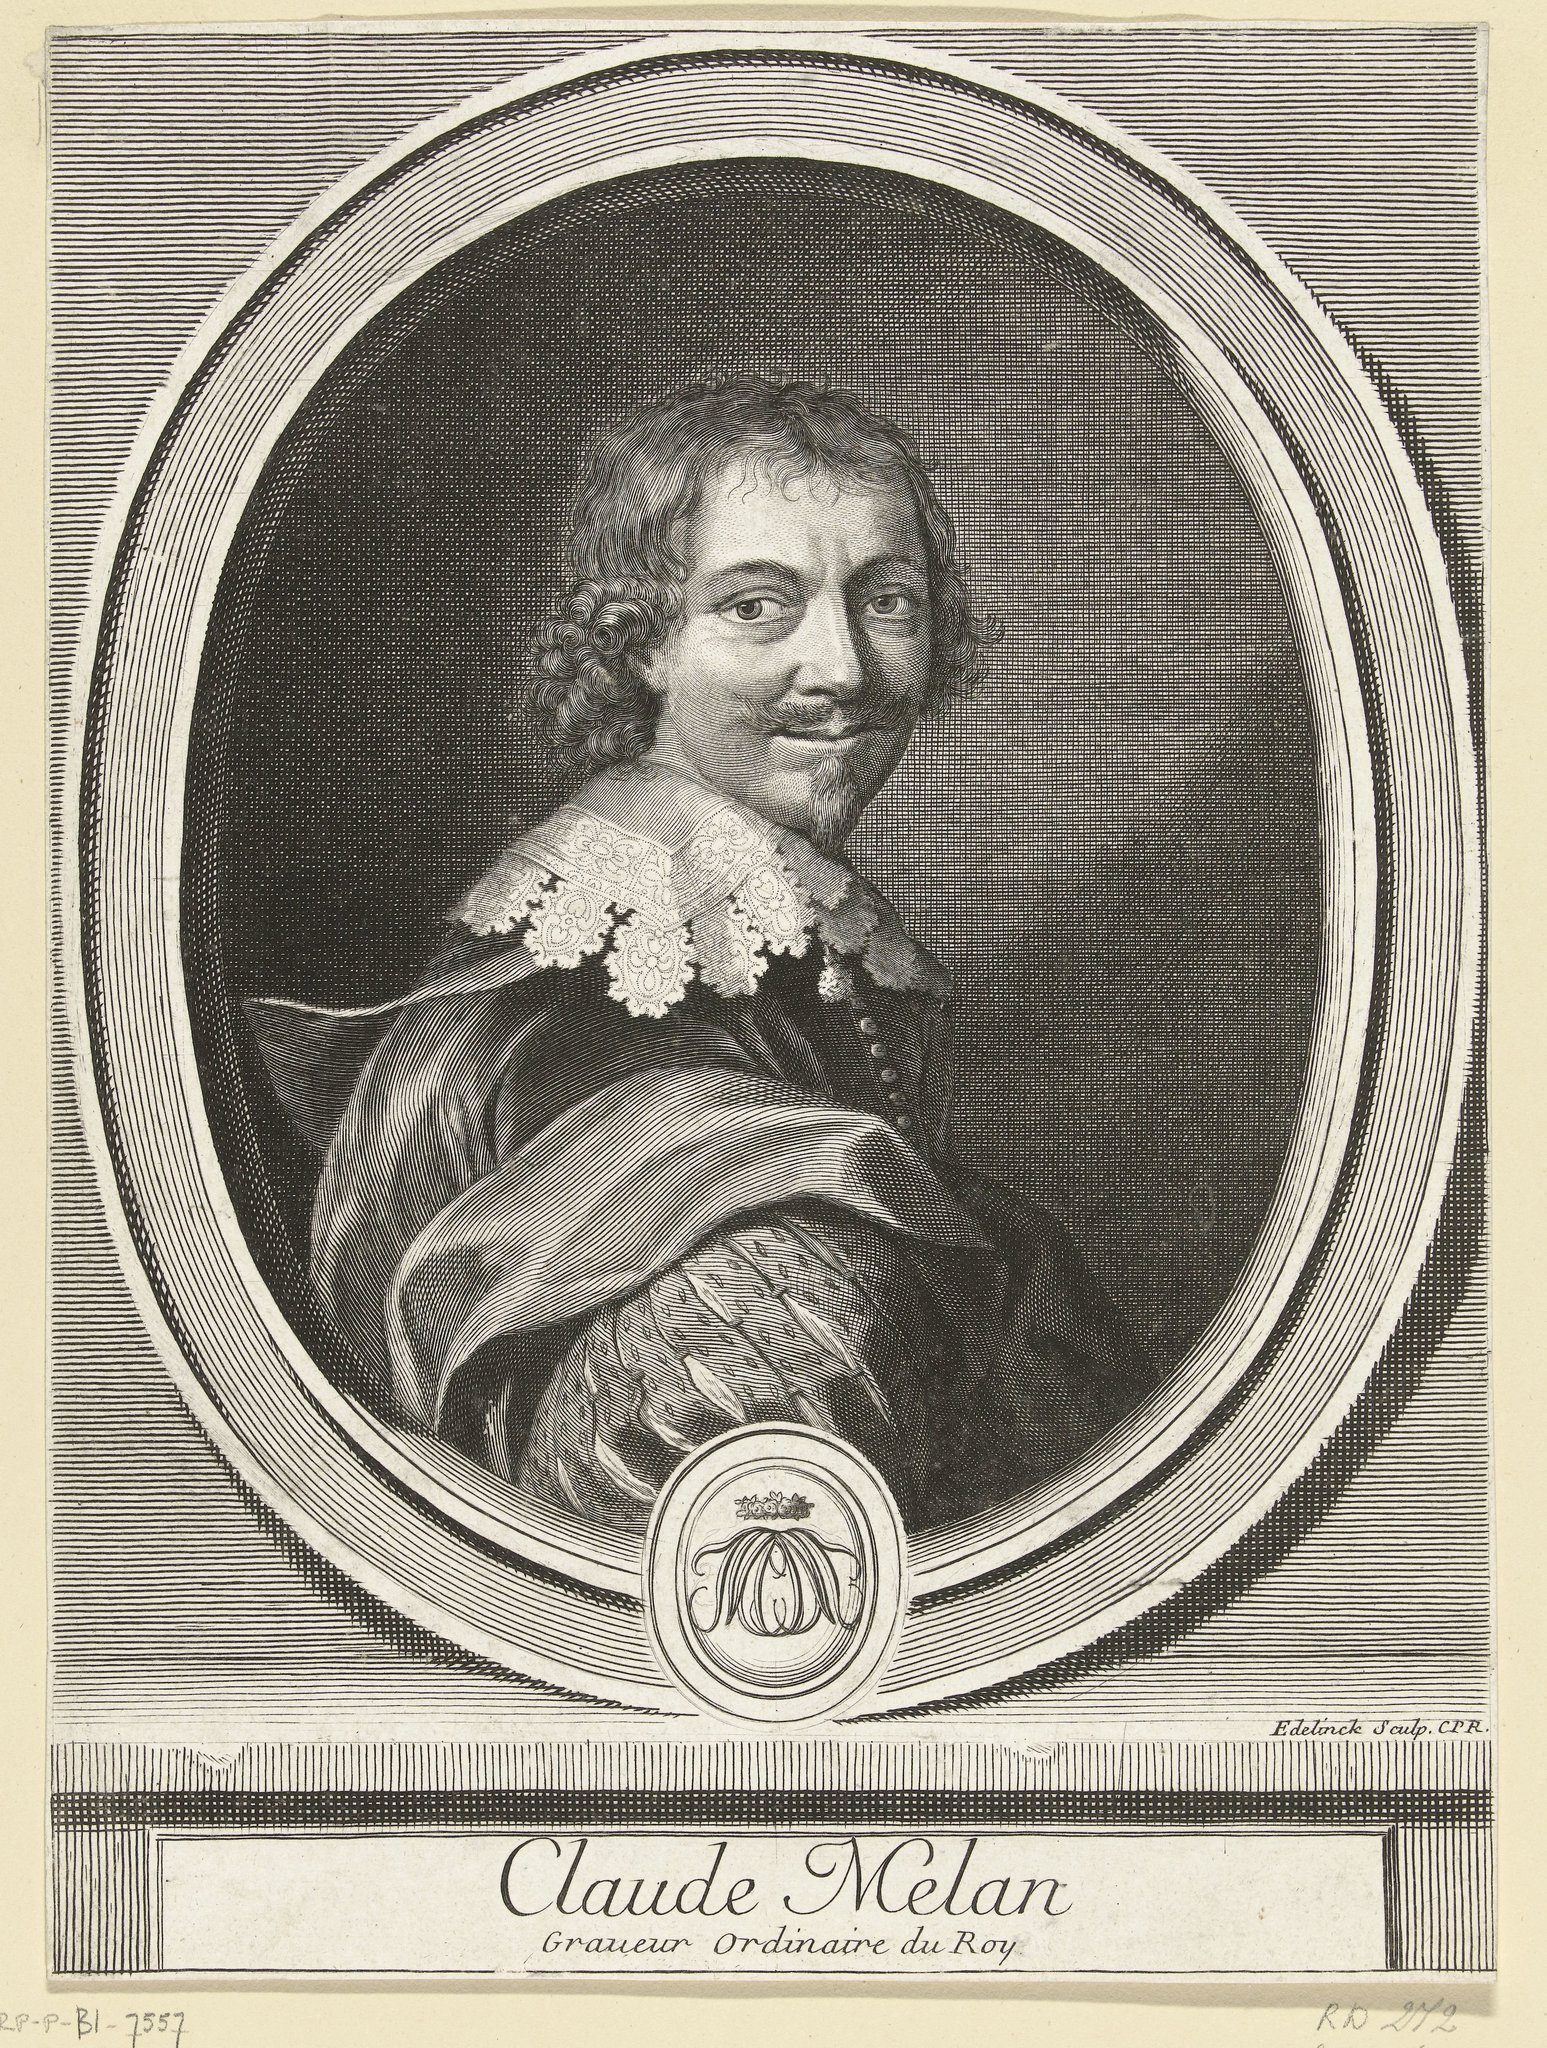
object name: print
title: Claude Melan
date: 1666-1707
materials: paper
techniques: engraving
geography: france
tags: paris, draughtsman, claude mellan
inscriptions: collector's mark: Lugt 240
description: Portret van de Franse schilder en prentmaker Claude Mellan (1598-1688), afgebeeld in ovale omlijsting met wapen.